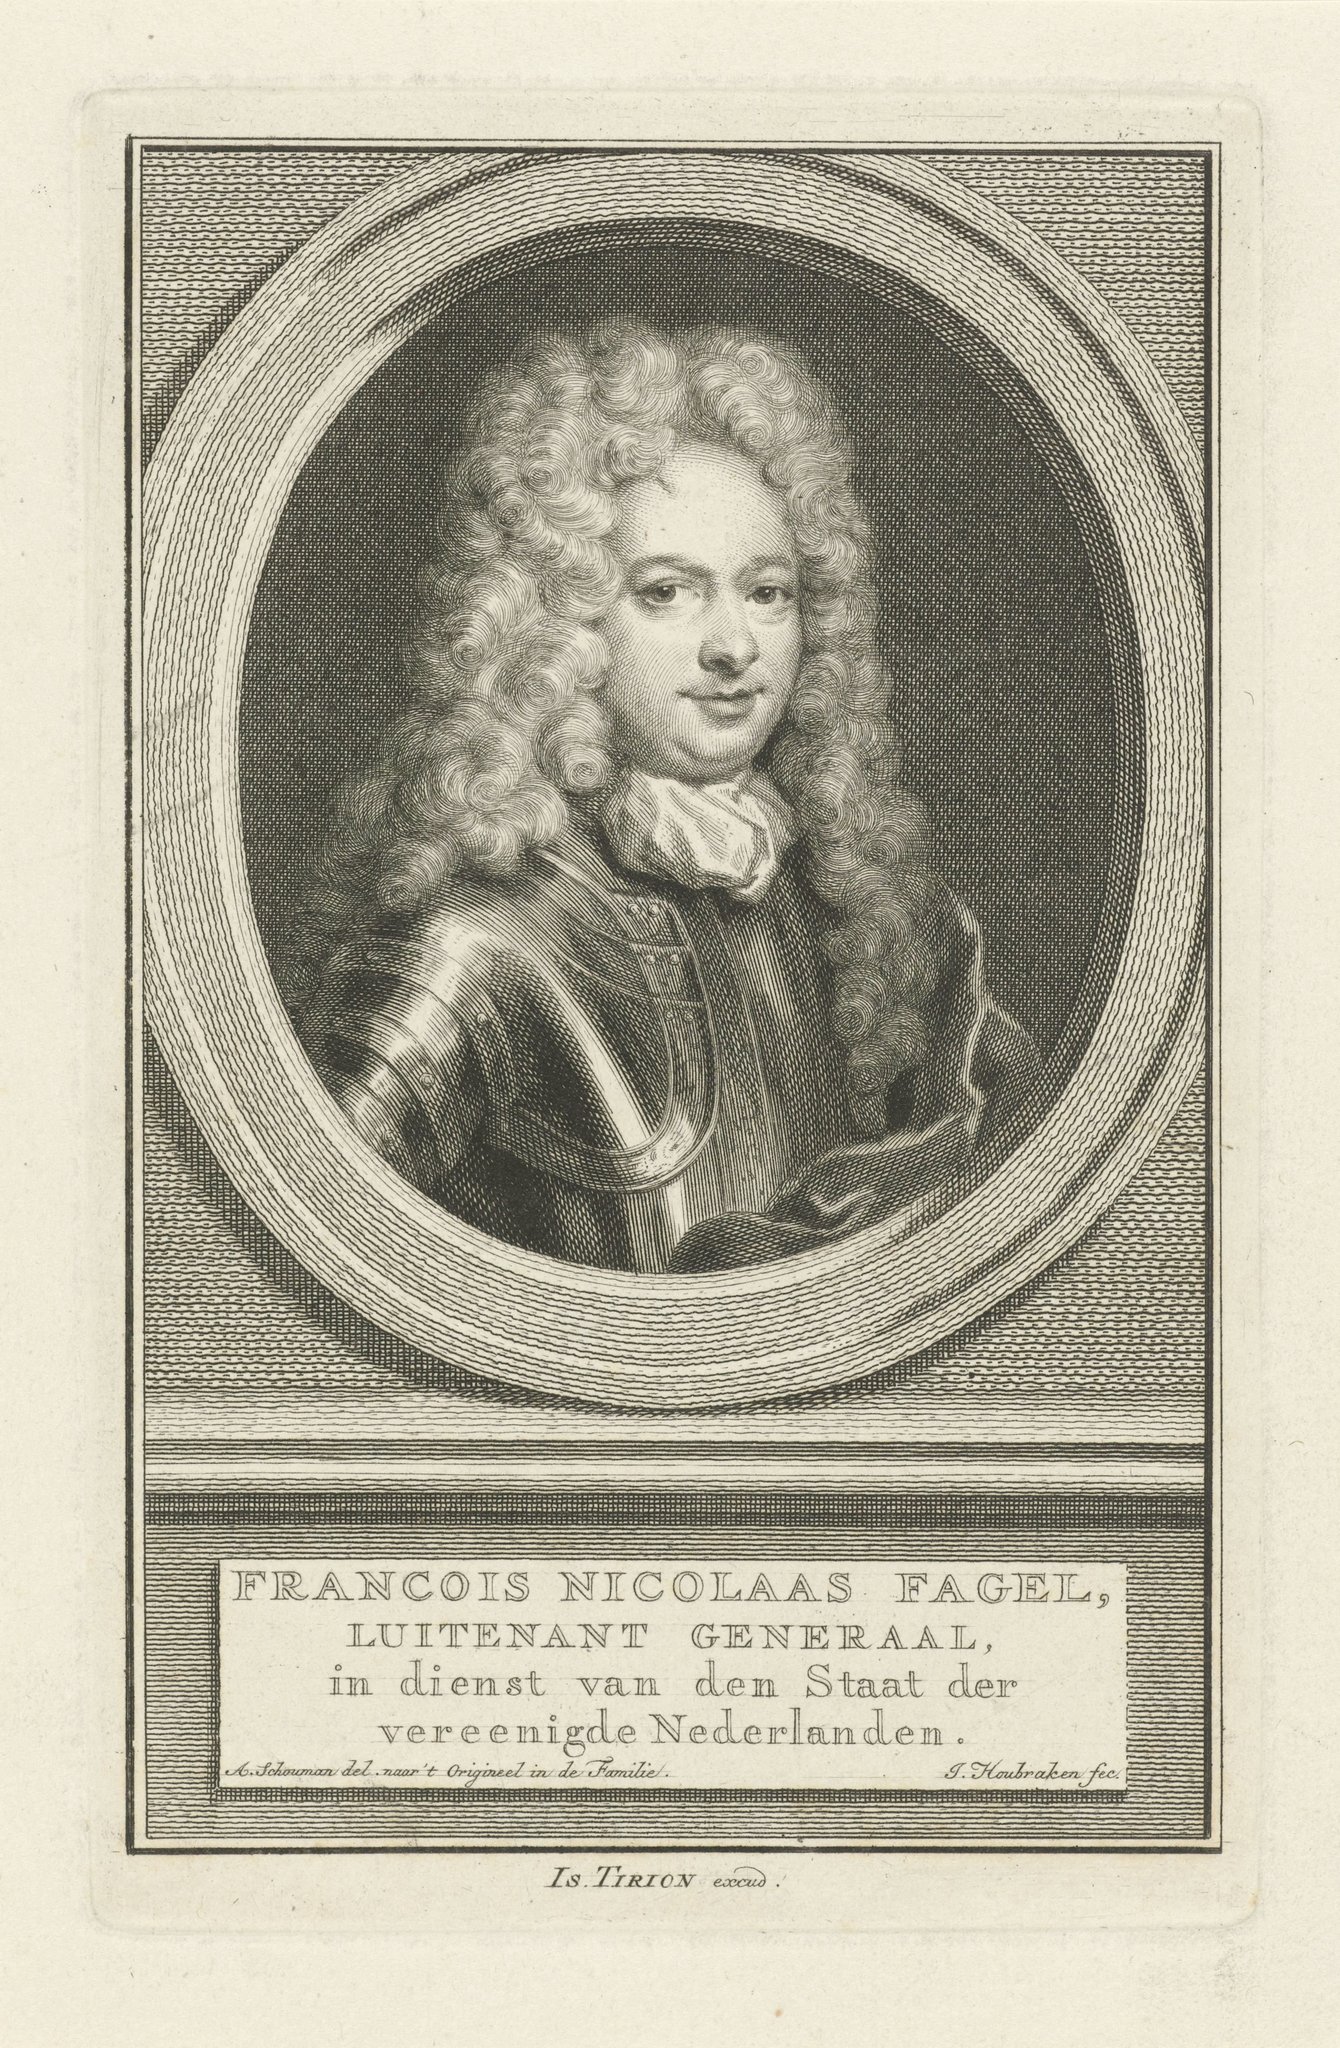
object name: print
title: Portret van François Nicolaas Fagel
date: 1749-1759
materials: paper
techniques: engraving, etching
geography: amsterdam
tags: françois nicolaas fagel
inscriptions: collector's mark: Lugt 2228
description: Prent ook gebruikt in: Jan Wagenaar, Vaderlandsche historie, vervattende de geschiedenissen der nu Vereenigde Nederlanden, inzonderheid die van Holland (...), 21 delen. Amsterdam, Isaak Tirion, 1749-59.